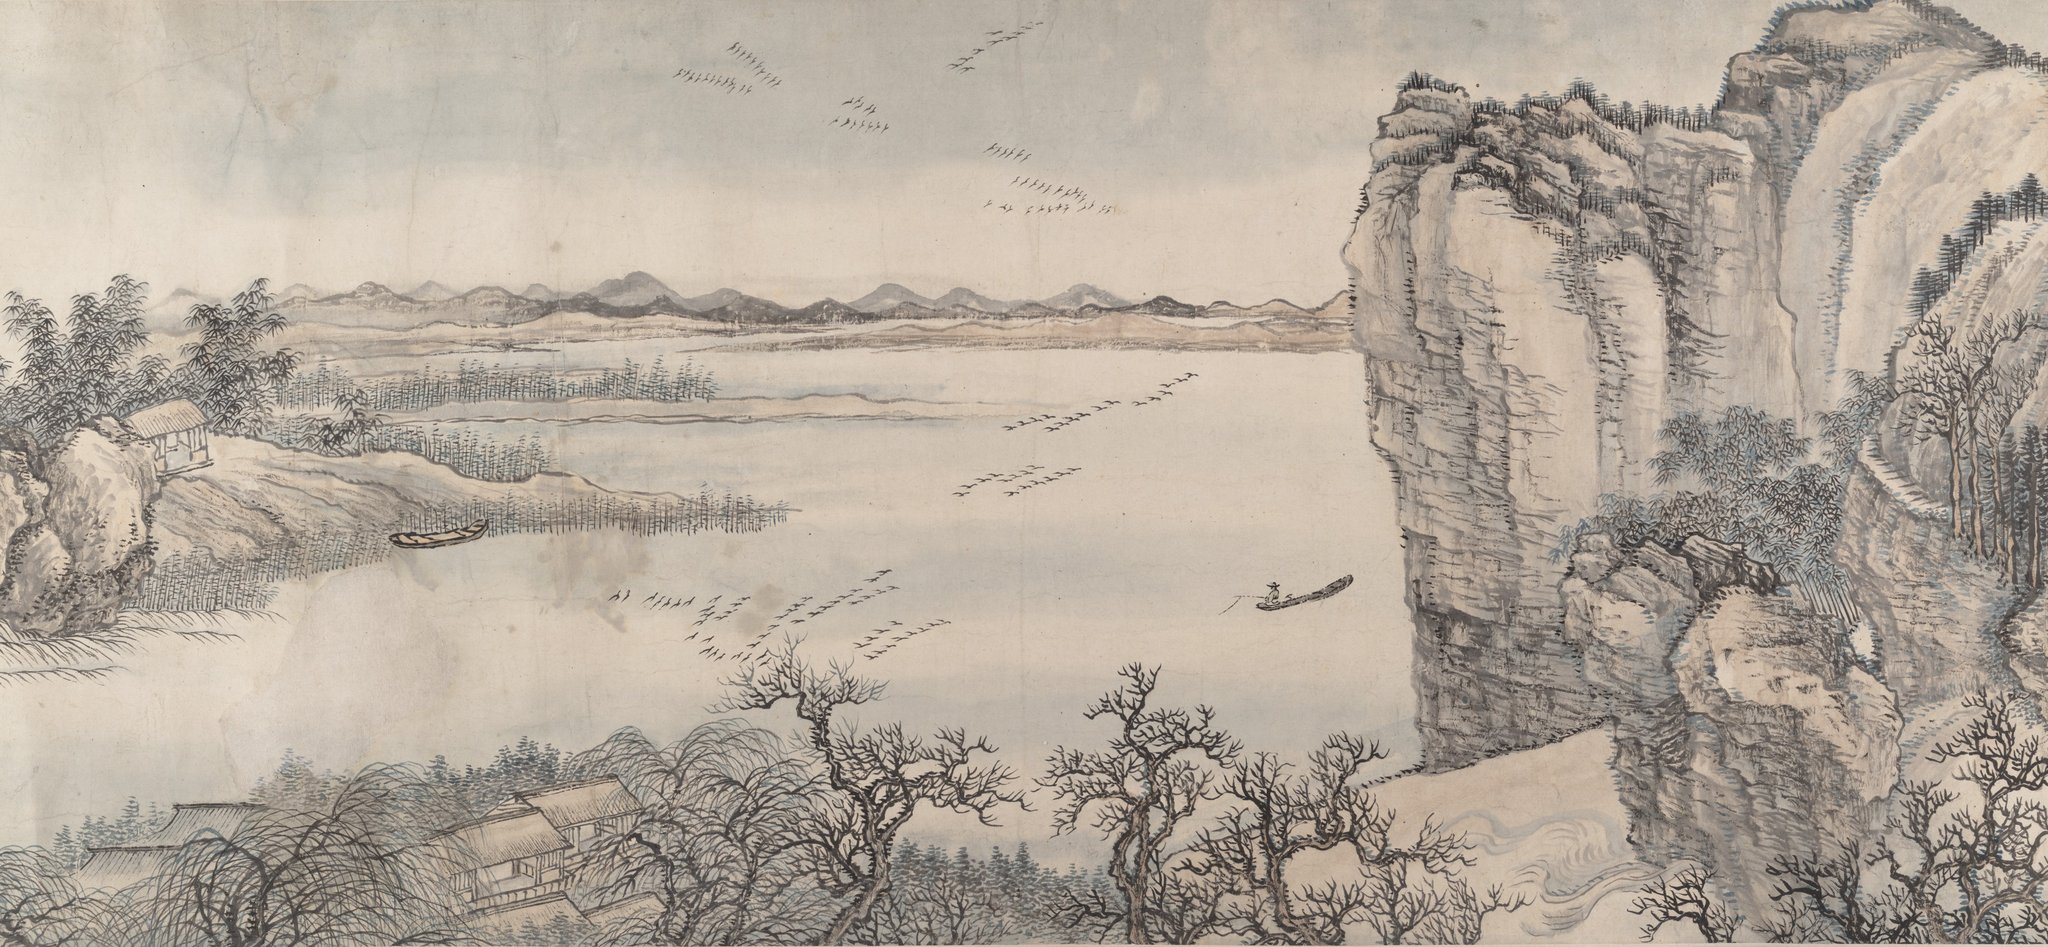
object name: handscroll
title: Landscape in the Style of Juran and Yan Wengui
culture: chinese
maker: wang hui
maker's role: artist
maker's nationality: chinese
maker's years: 1632-1717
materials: ink, paper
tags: mountains,landscapes,boats